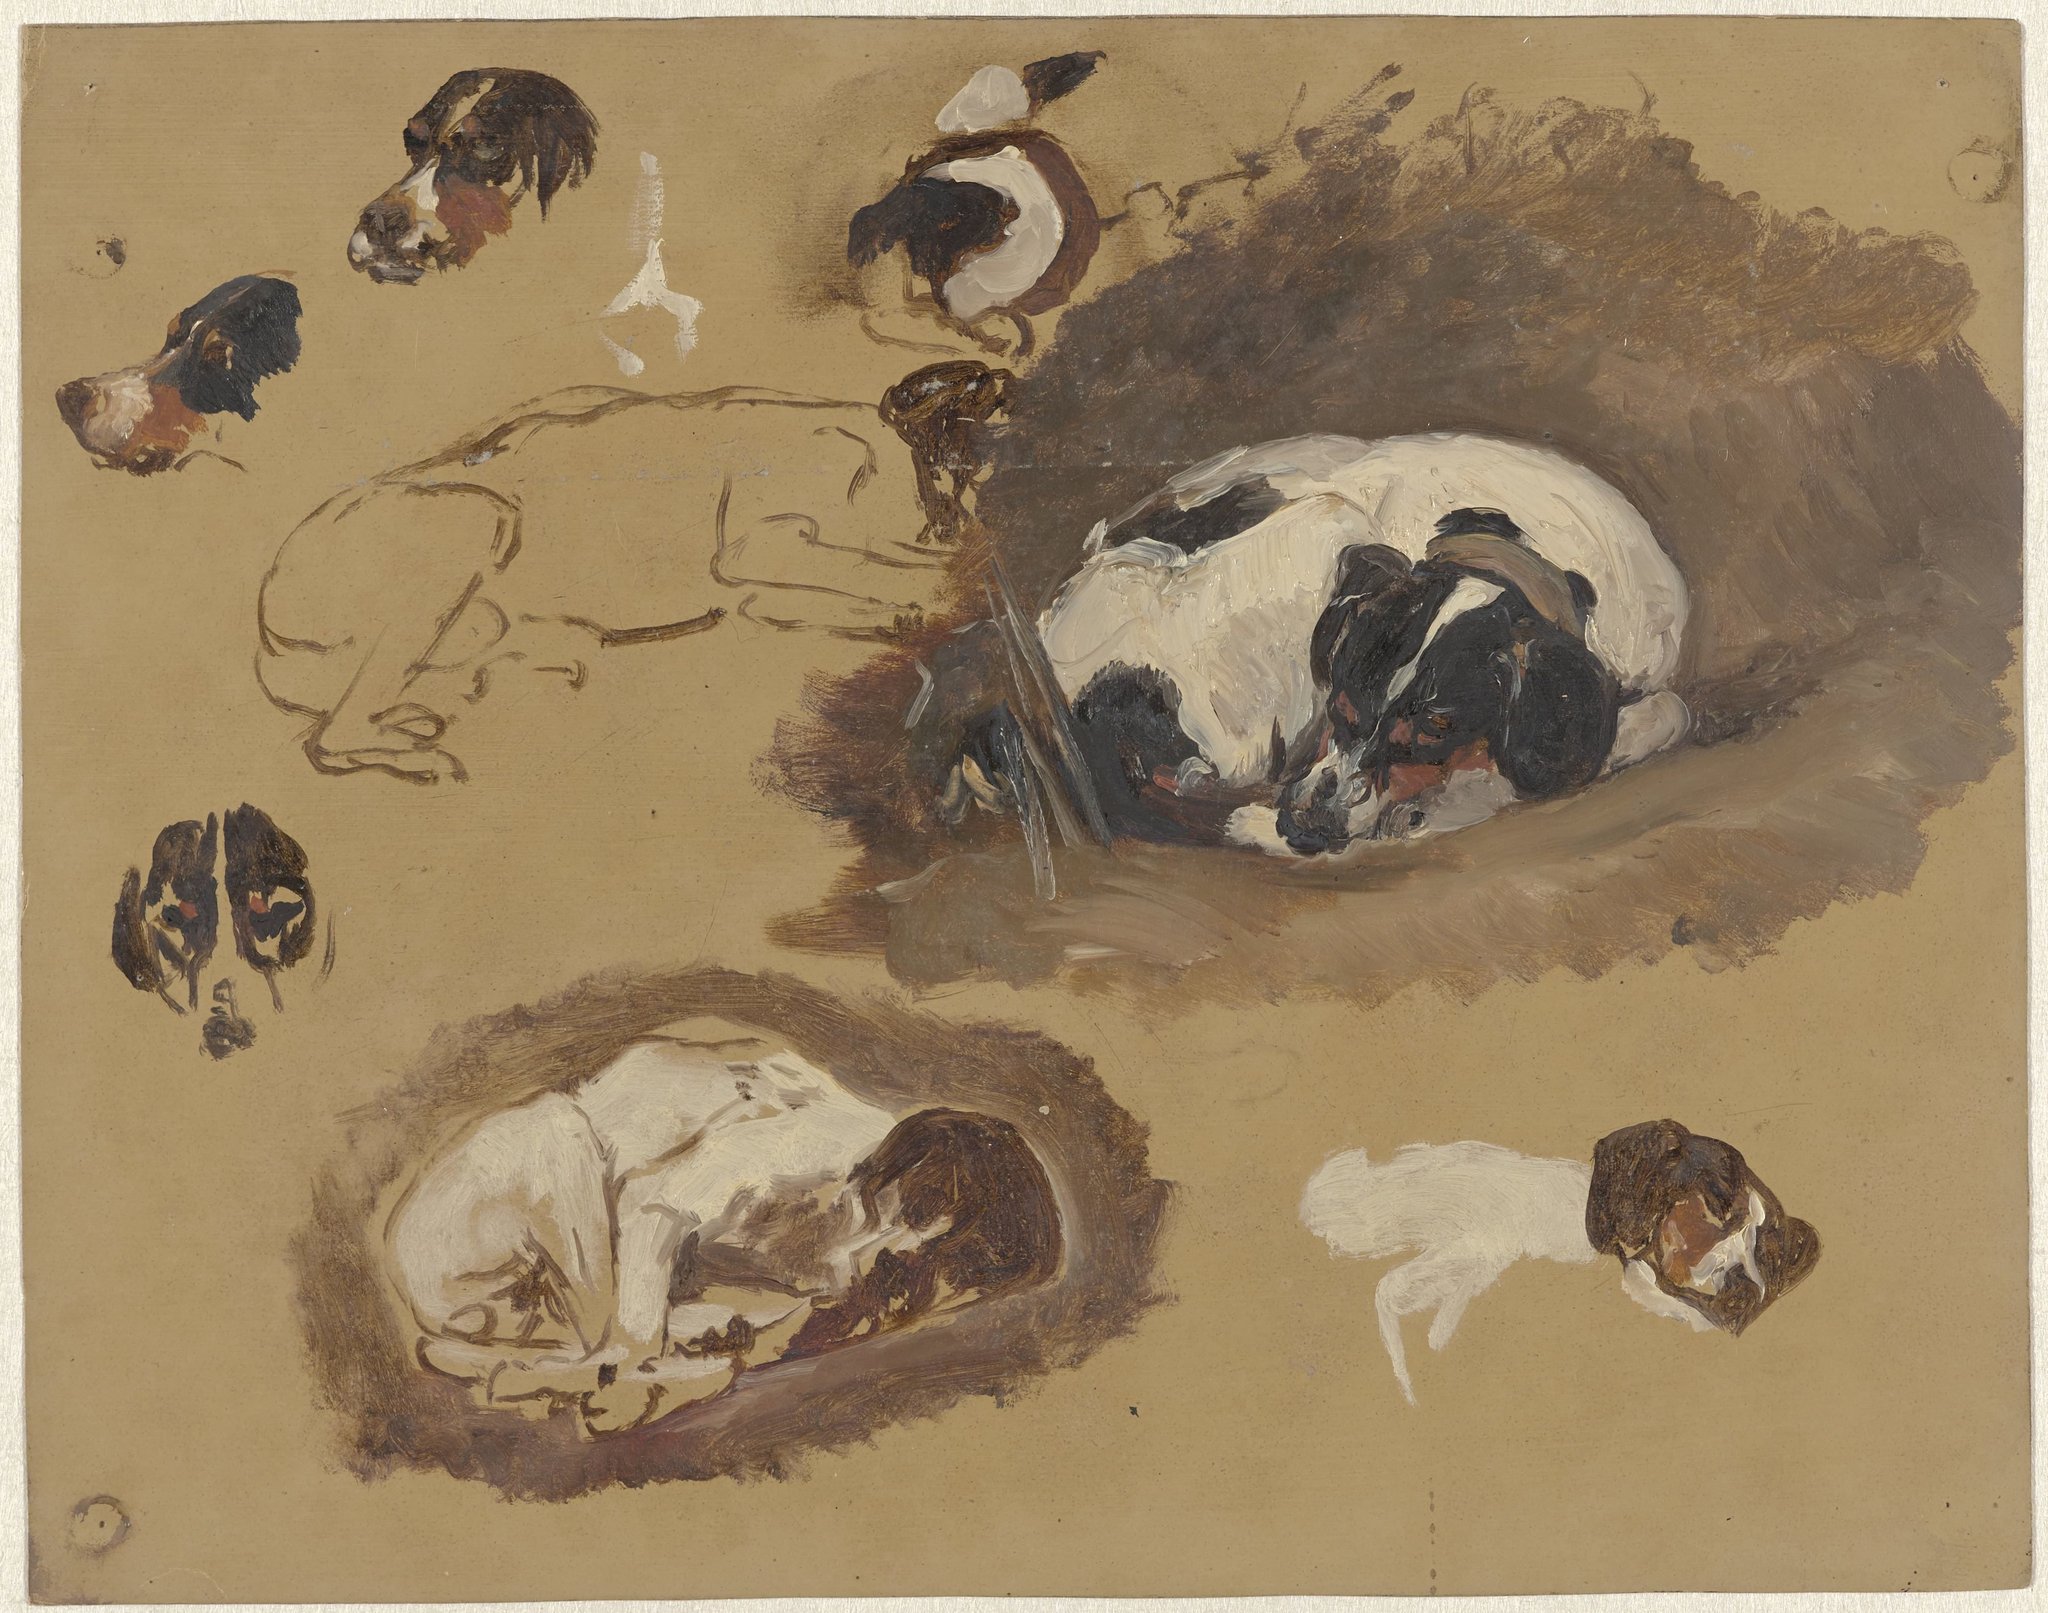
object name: drawing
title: Studies van een jachthond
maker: guillaume anne van der brugghen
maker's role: draughtsman, print maker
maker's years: 1812-1891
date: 1821-1891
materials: oil, paper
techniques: brush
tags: dog